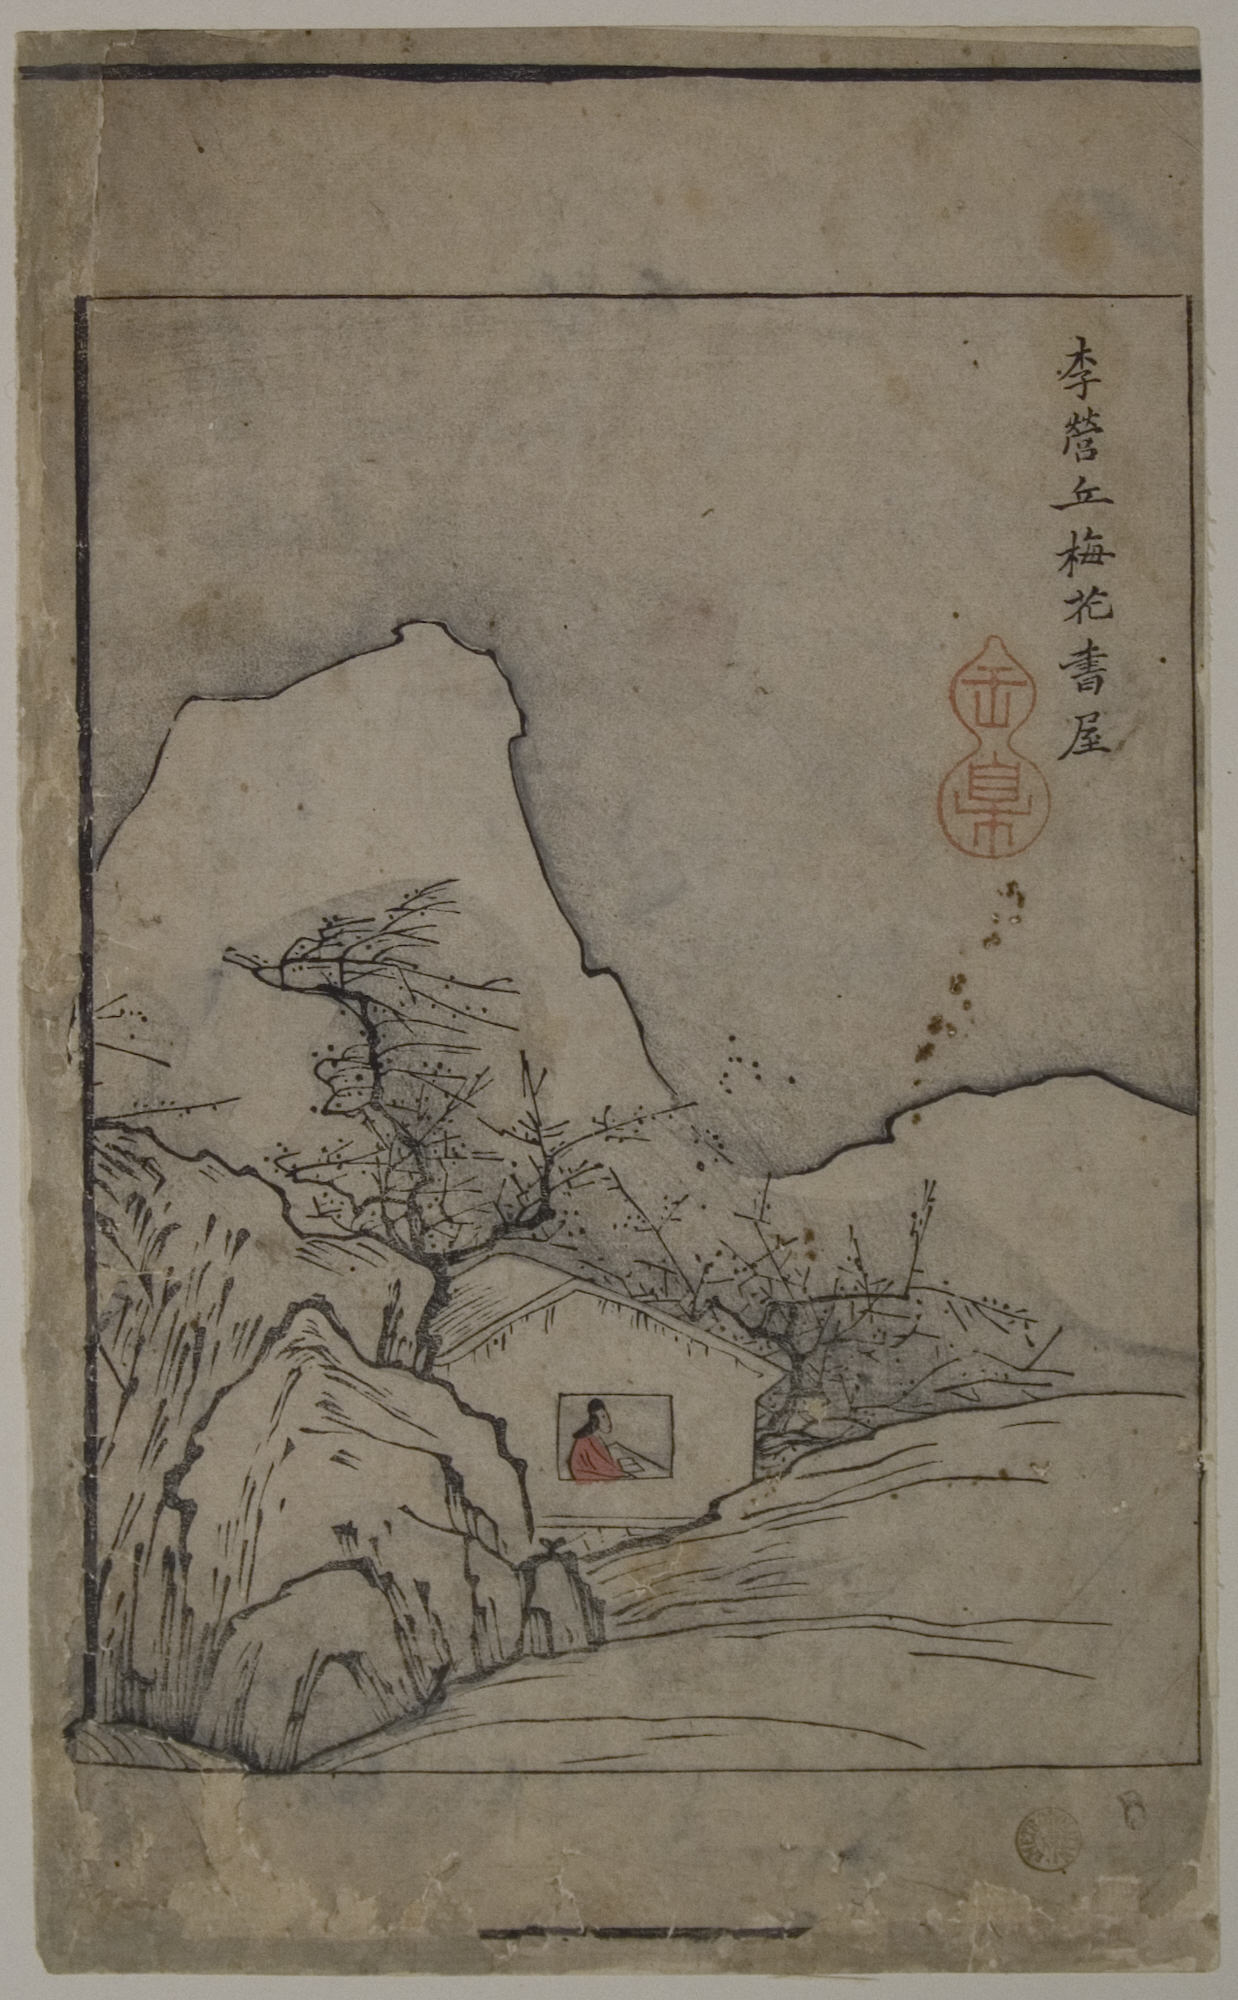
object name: print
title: Study Pavilion and Plum Trees: Page from The Mustard Seed Garden Manual of Painting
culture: chinese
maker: li cheng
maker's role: artist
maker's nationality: chinese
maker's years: 919-967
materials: ink, paper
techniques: polychrome, woodblock print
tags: human figures,trees